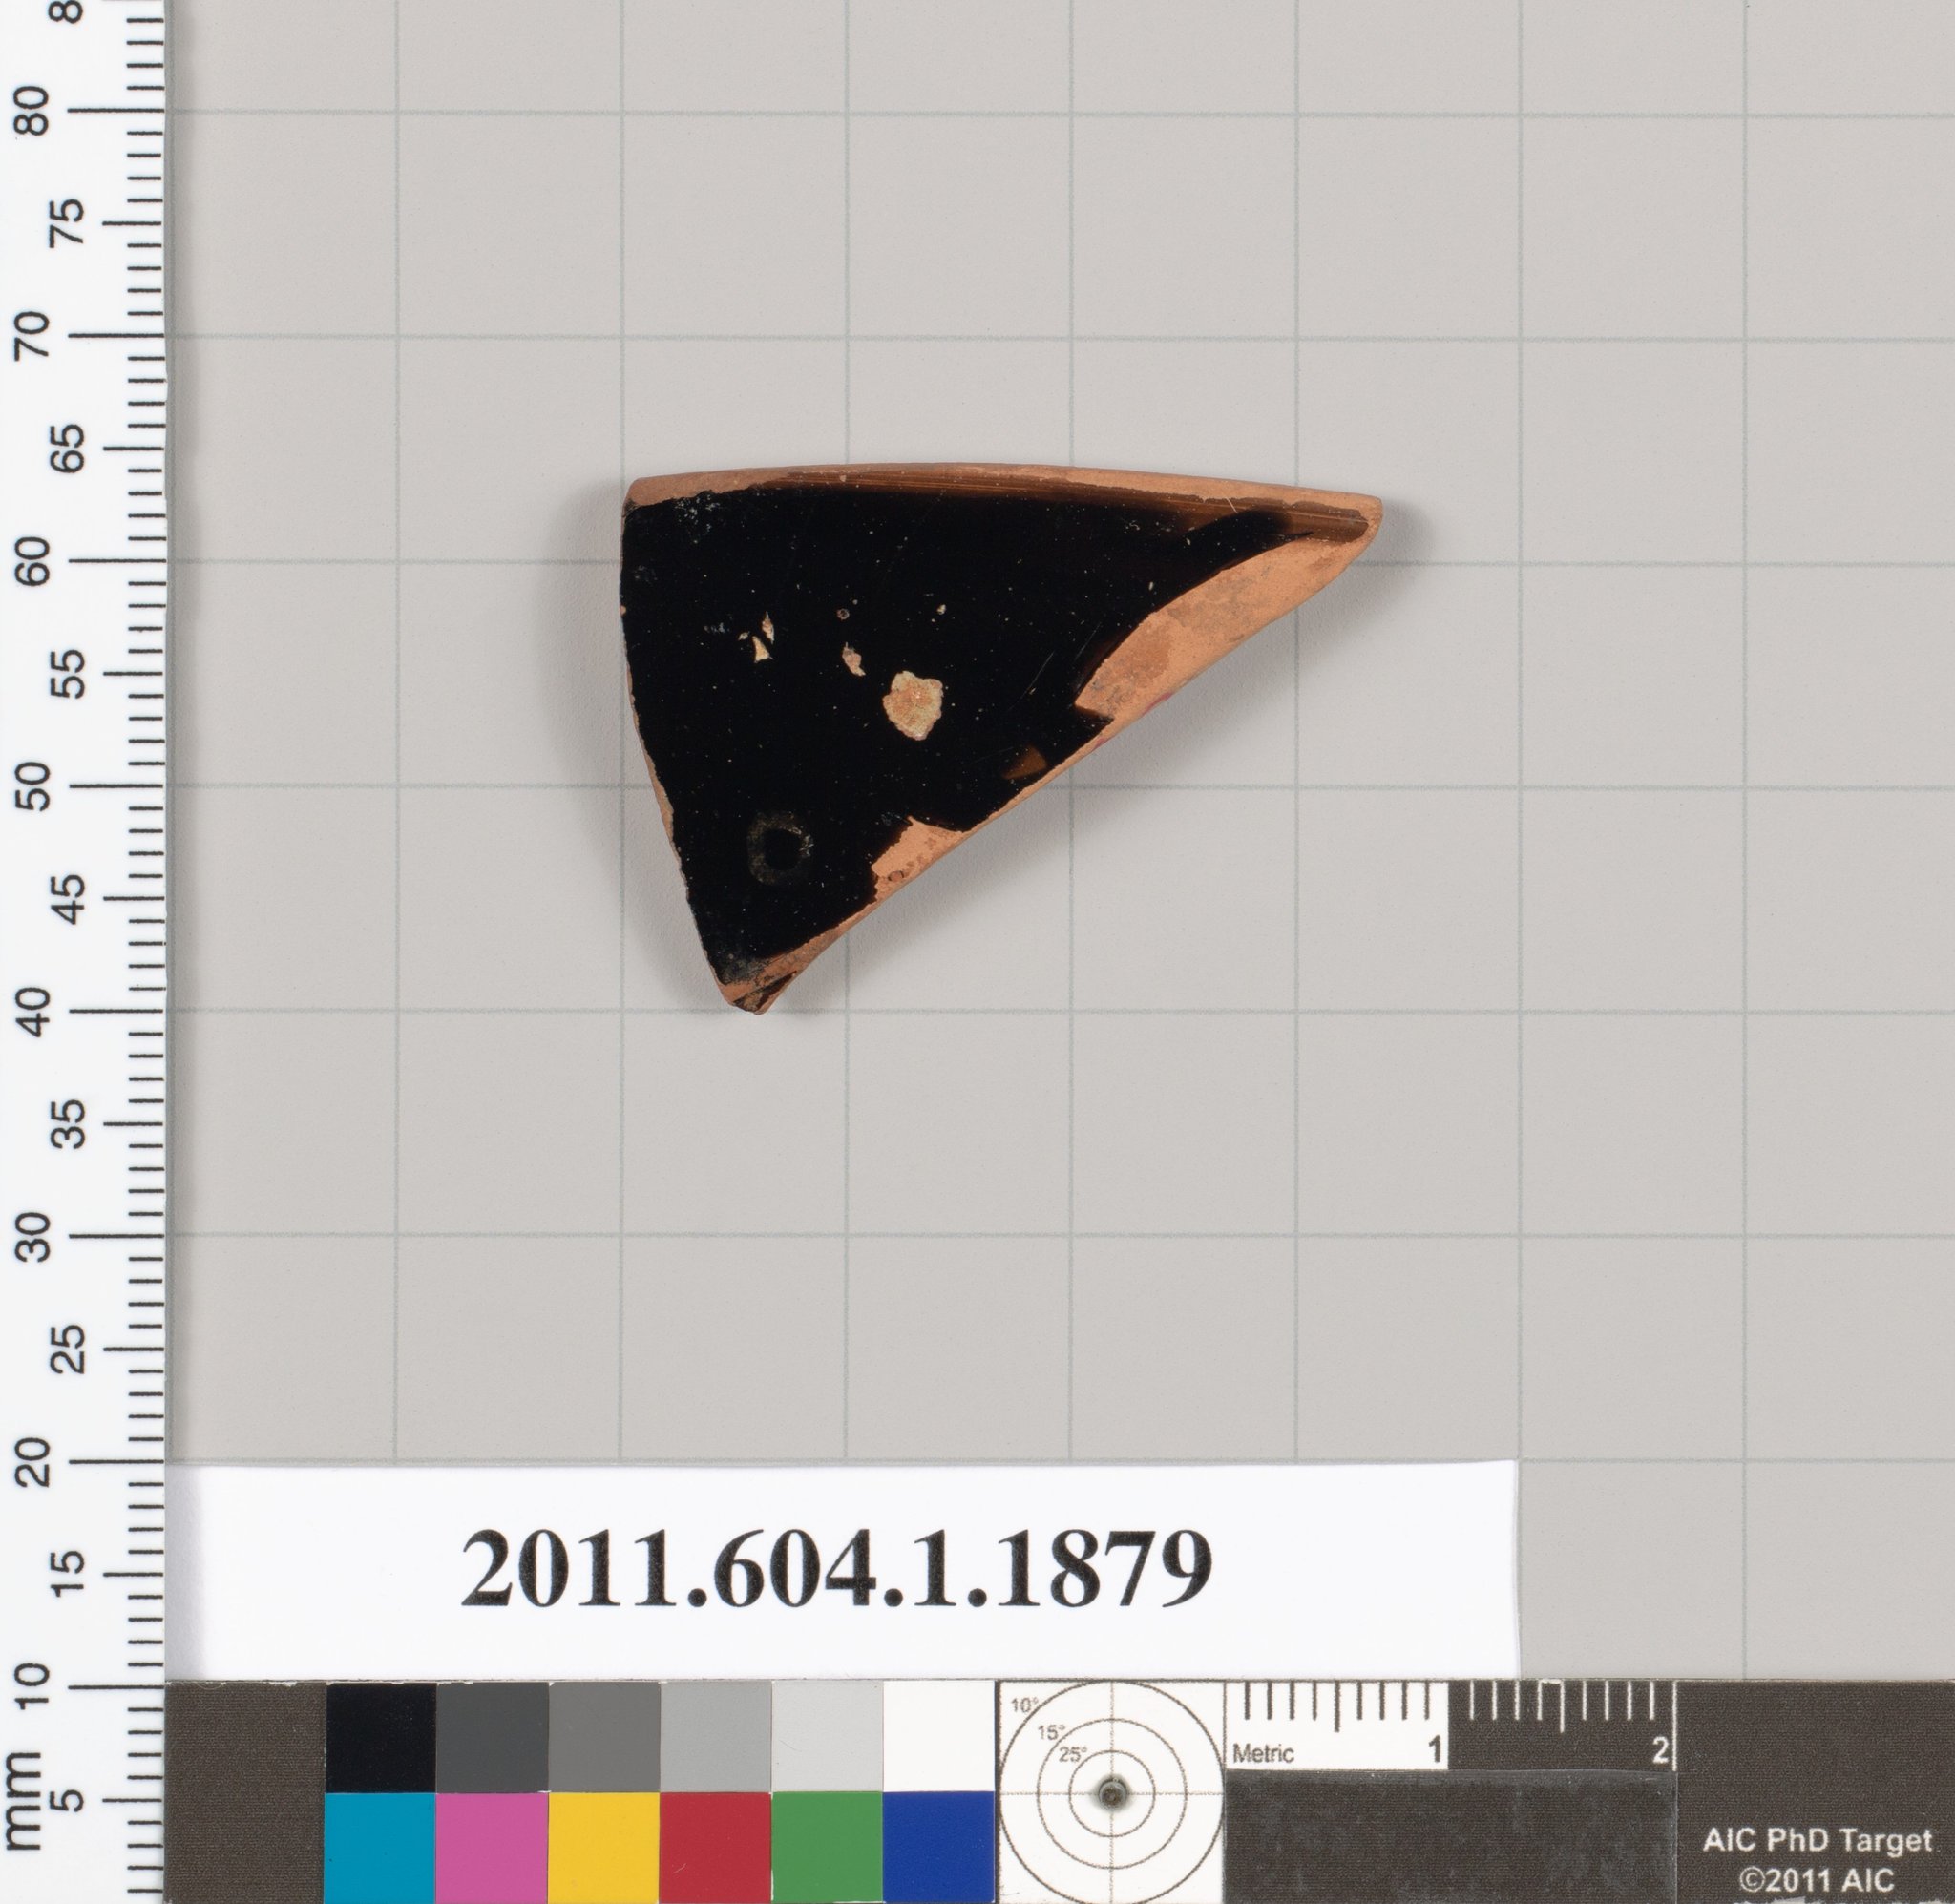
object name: kylix fragment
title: Terracotta rim fragment of a kylix (drinking cup)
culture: greek, attic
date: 500-451 BCE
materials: terracotta